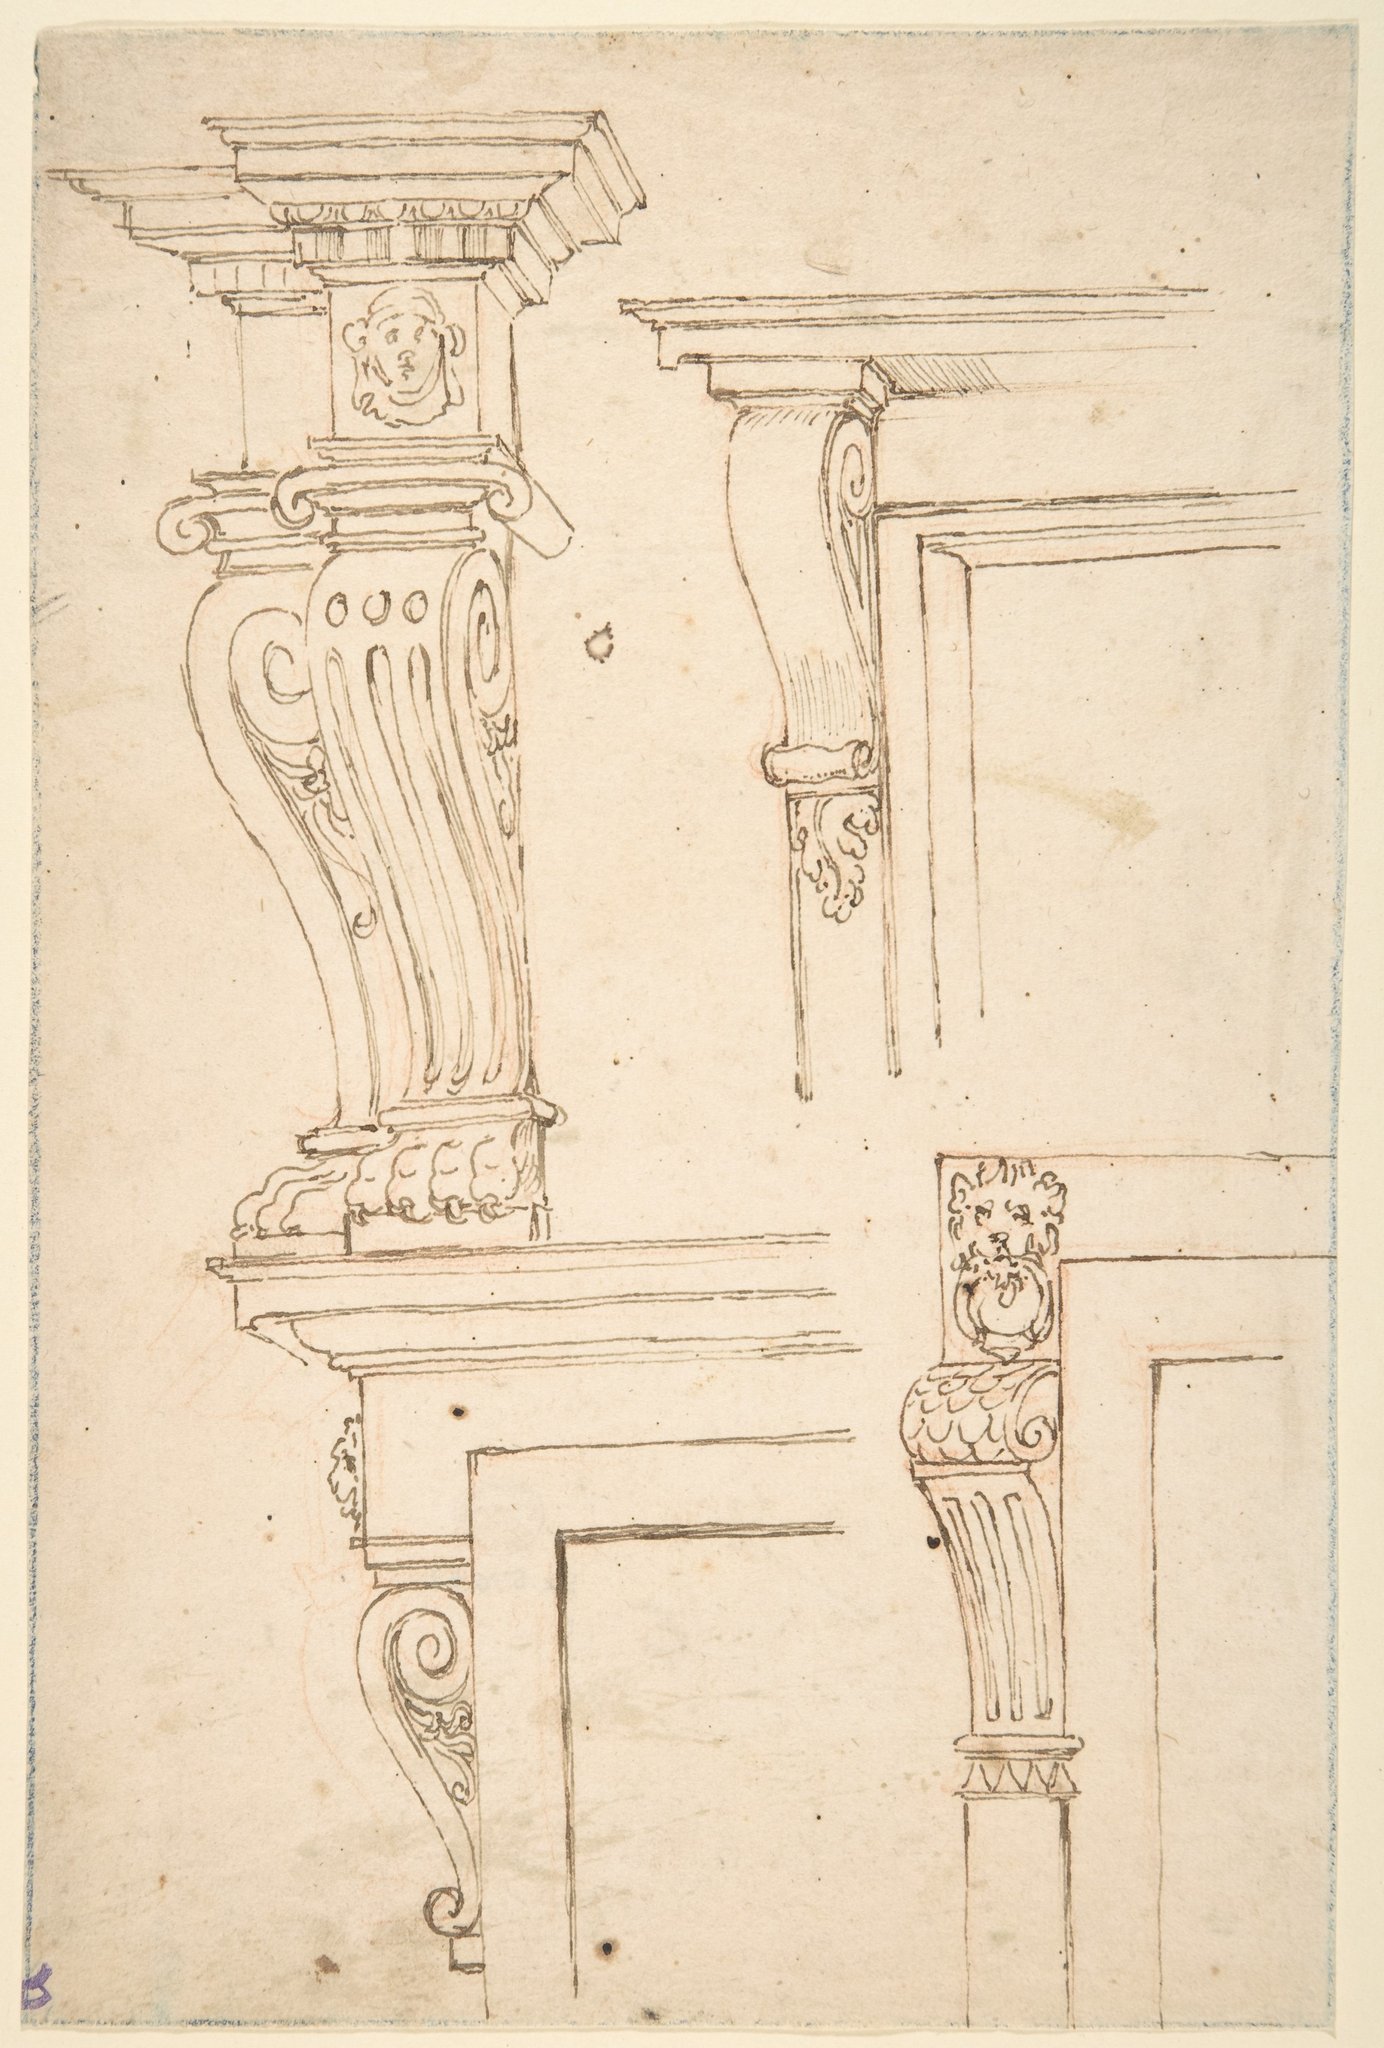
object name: drawing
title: Studies for Consoles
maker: anonymous, italian, 16th century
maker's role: artist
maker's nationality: italian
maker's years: 1500-1600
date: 1501-1600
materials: ink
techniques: pen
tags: architecture,faces